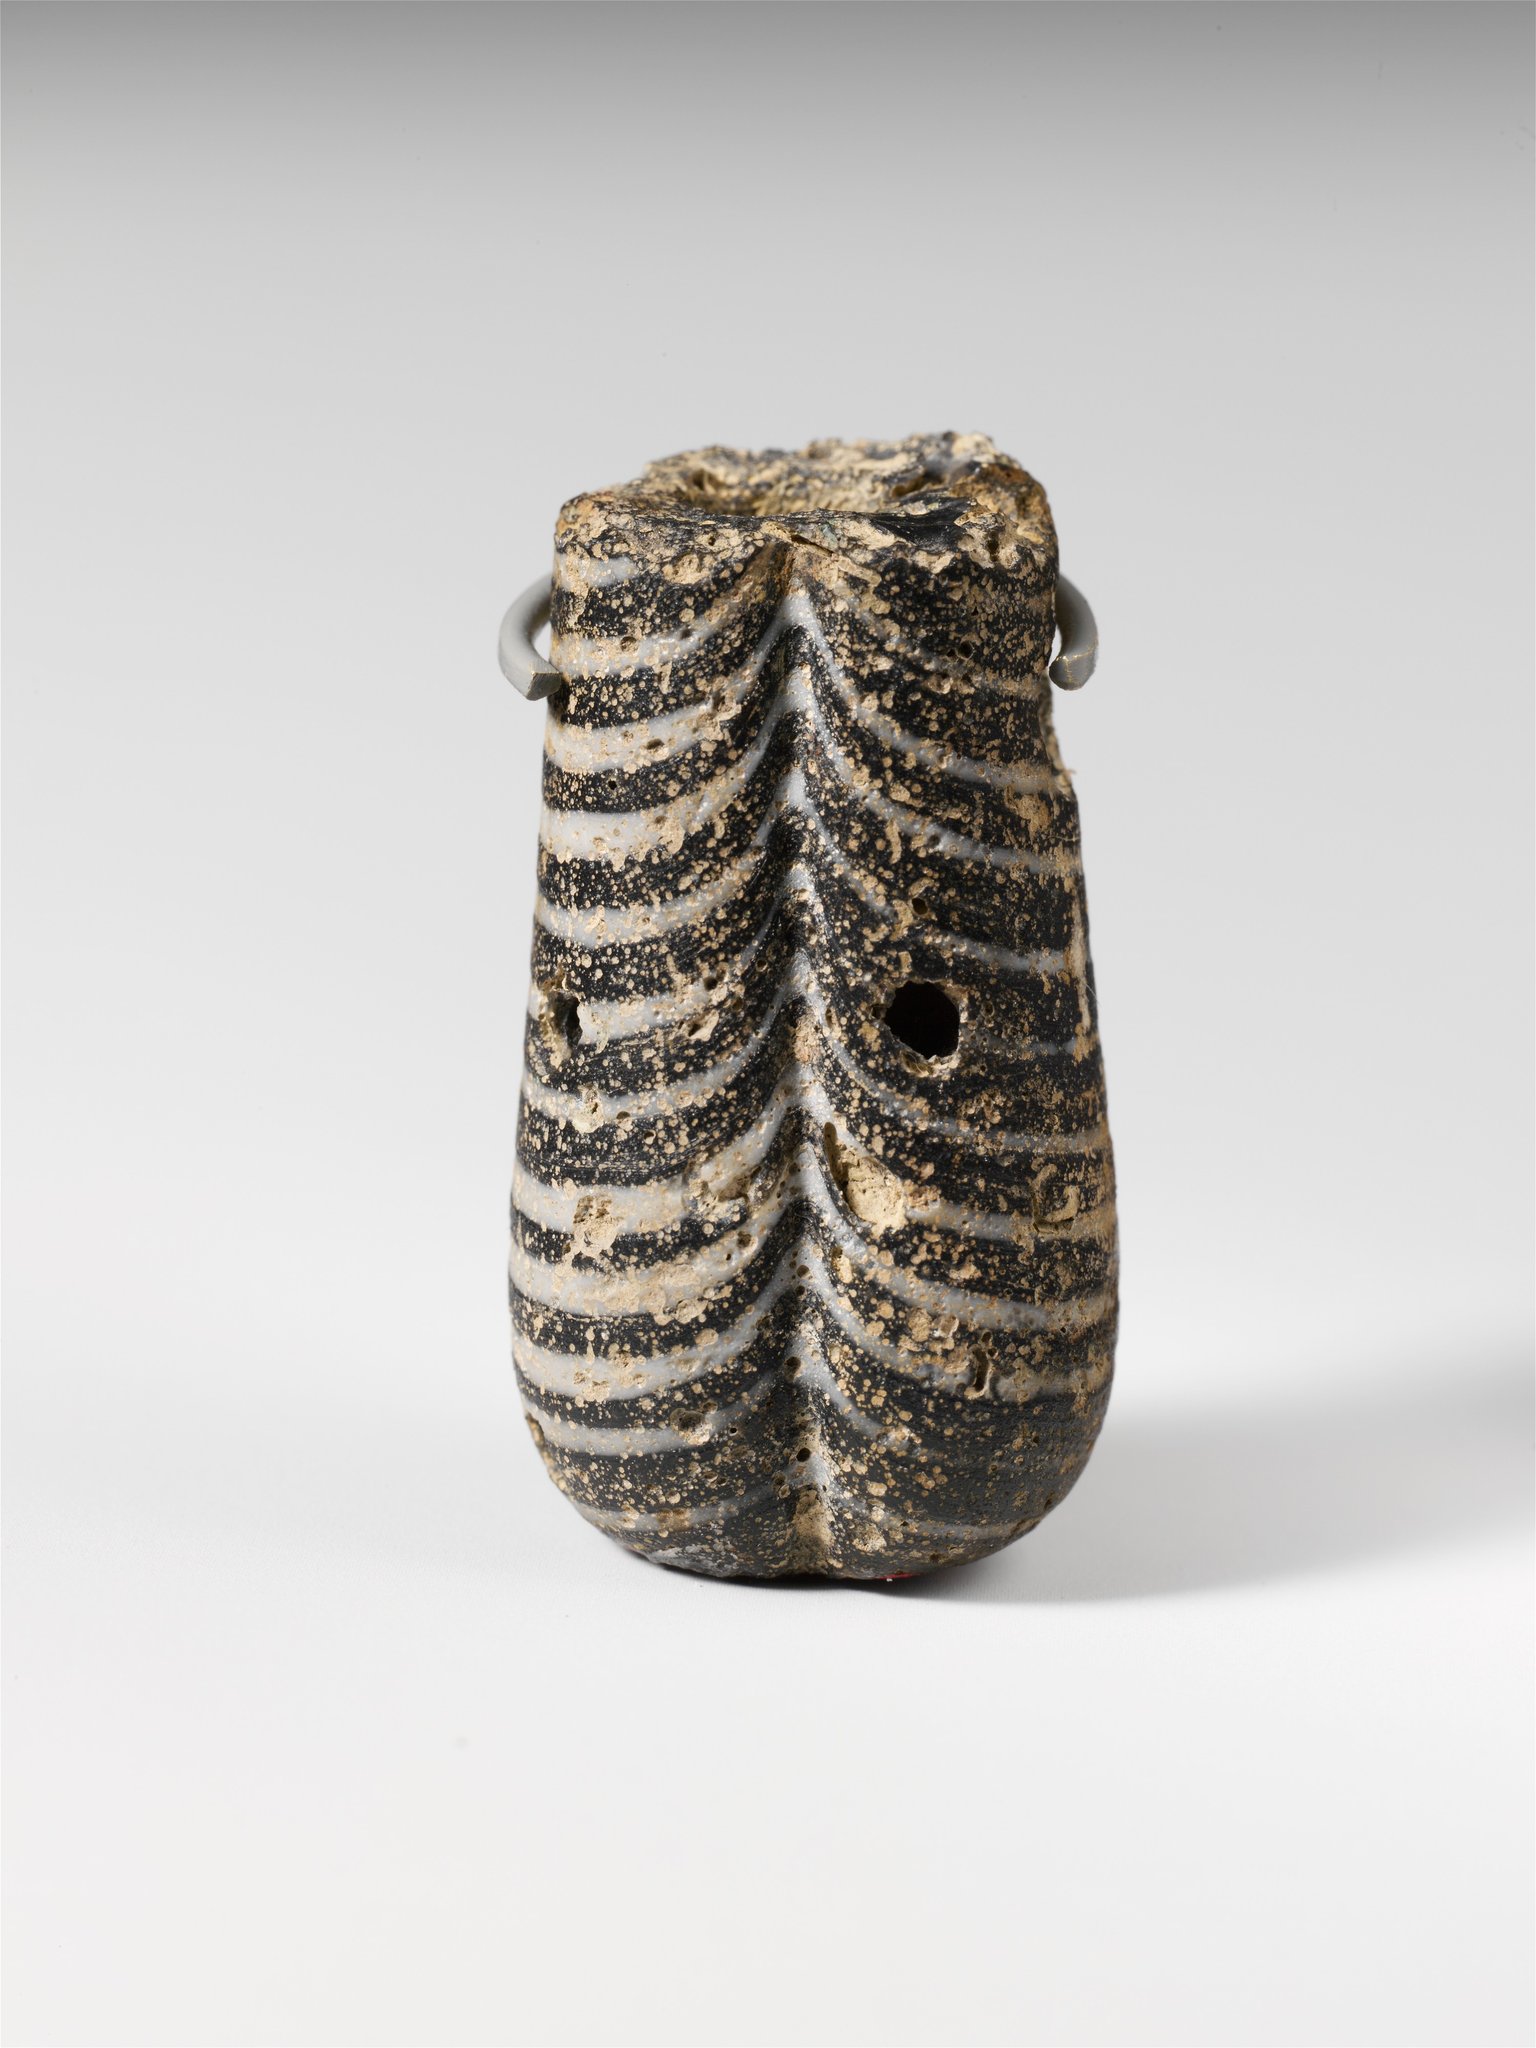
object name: plumbline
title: Glass pendant bead in the shape of a plumbline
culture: etruscan or greek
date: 700-401 BCE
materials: glass